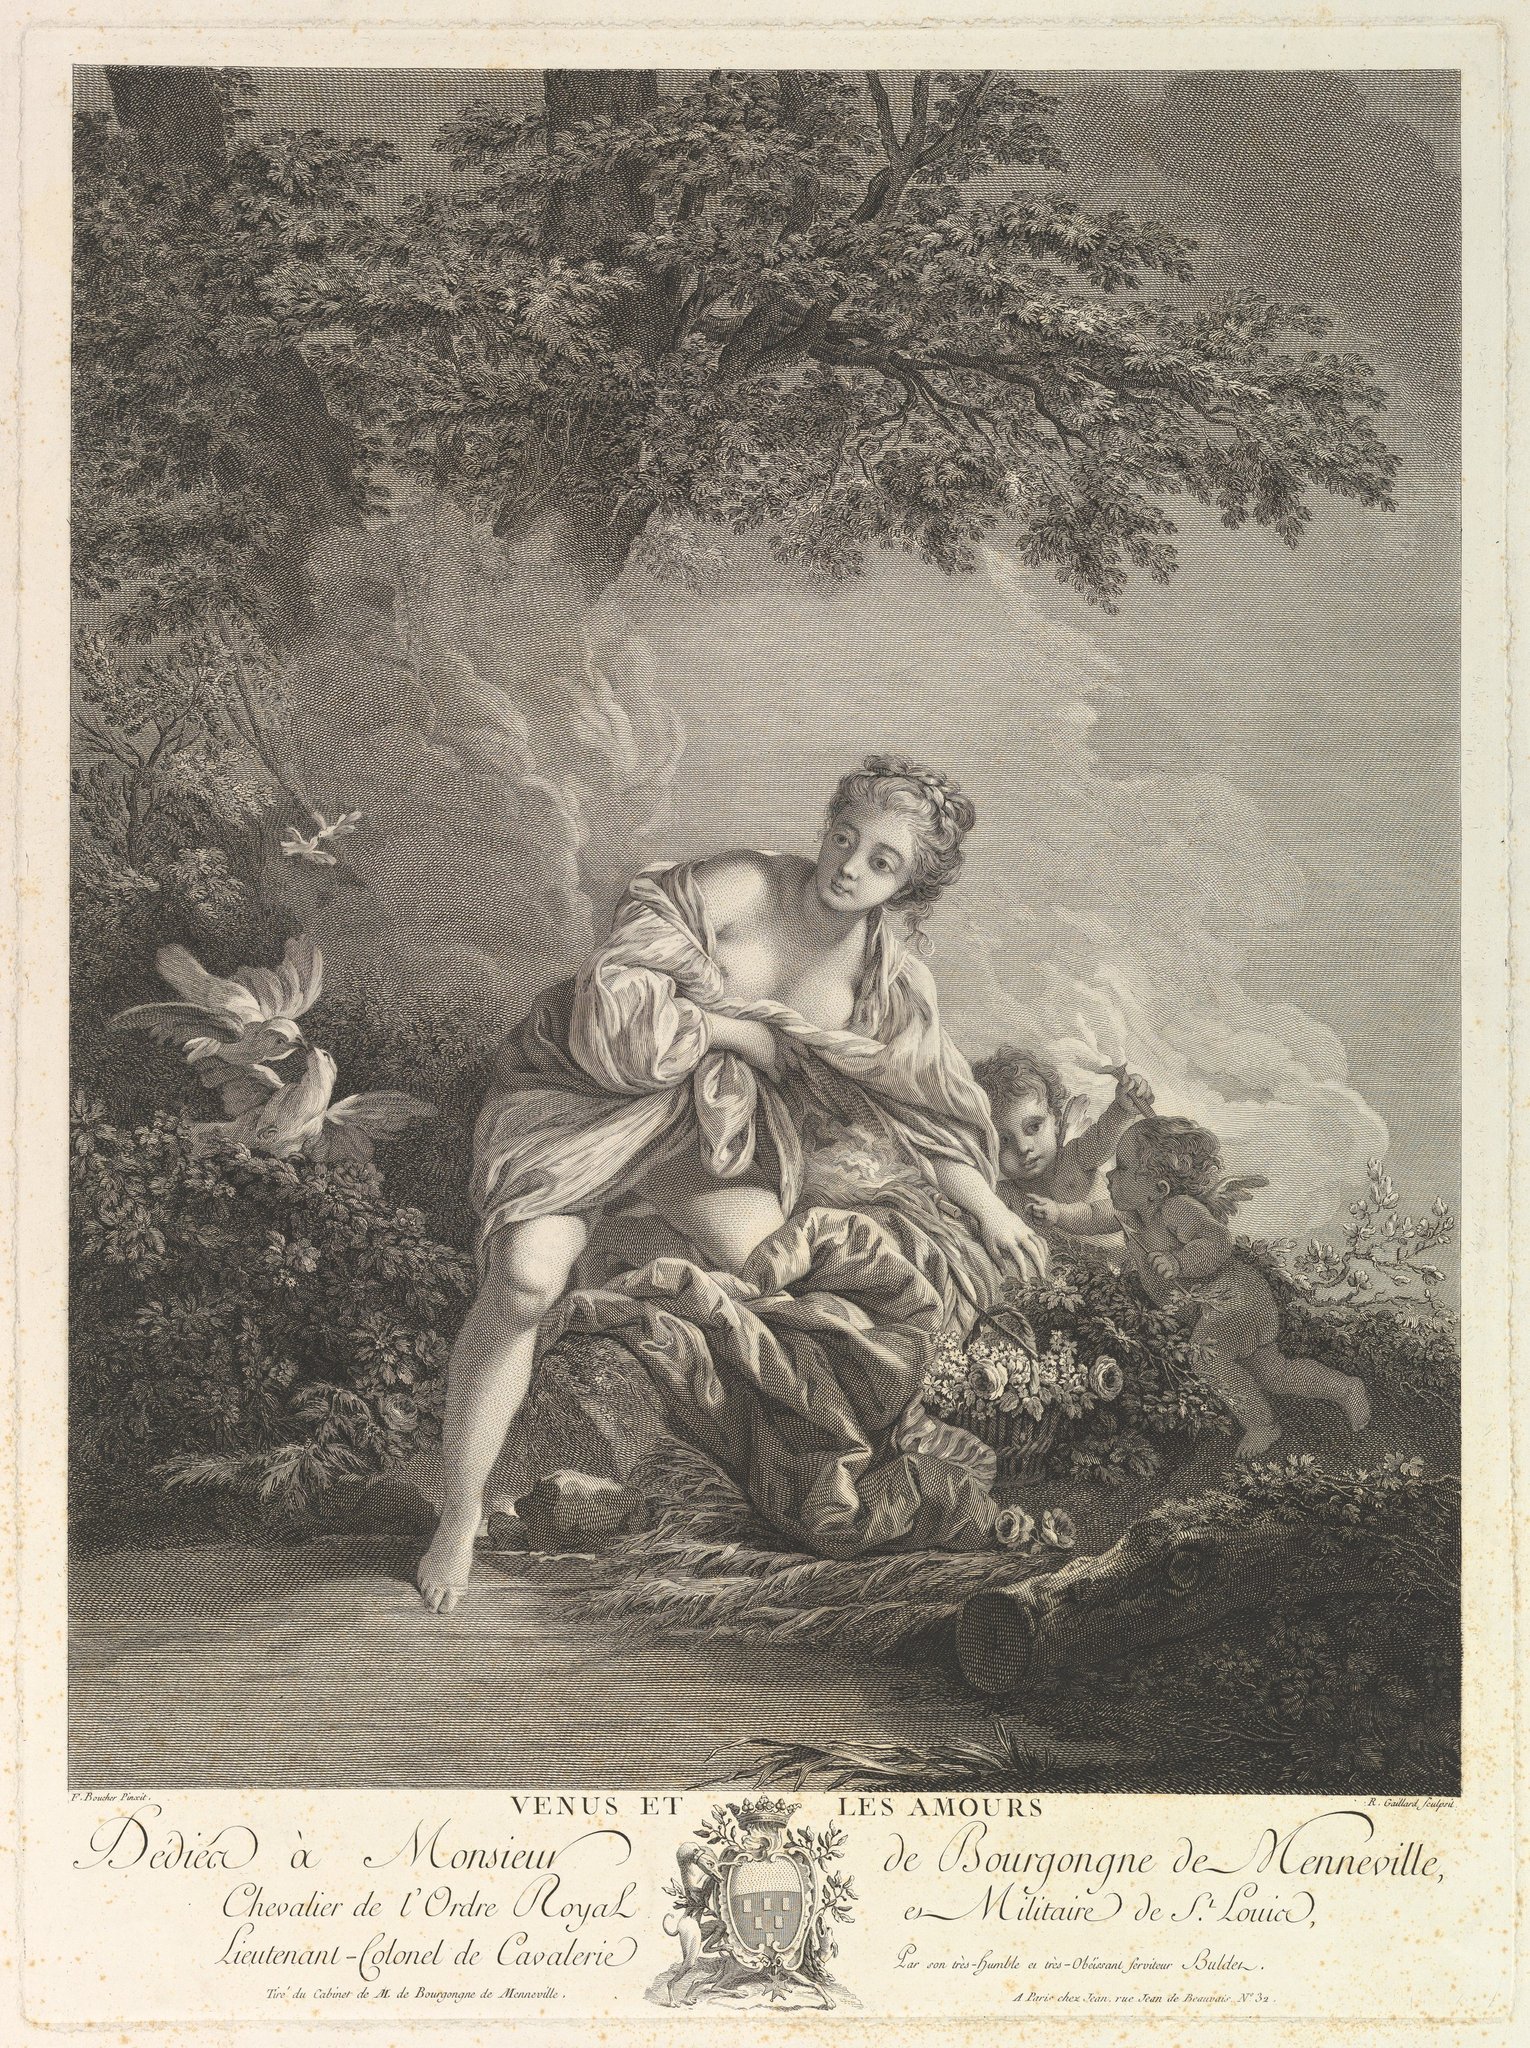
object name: print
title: Venus et les Amours (Venus and the Loves)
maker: rené gaillard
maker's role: artist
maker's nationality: french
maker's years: 1714-1790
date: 1701-1800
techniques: engraving, etching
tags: venus